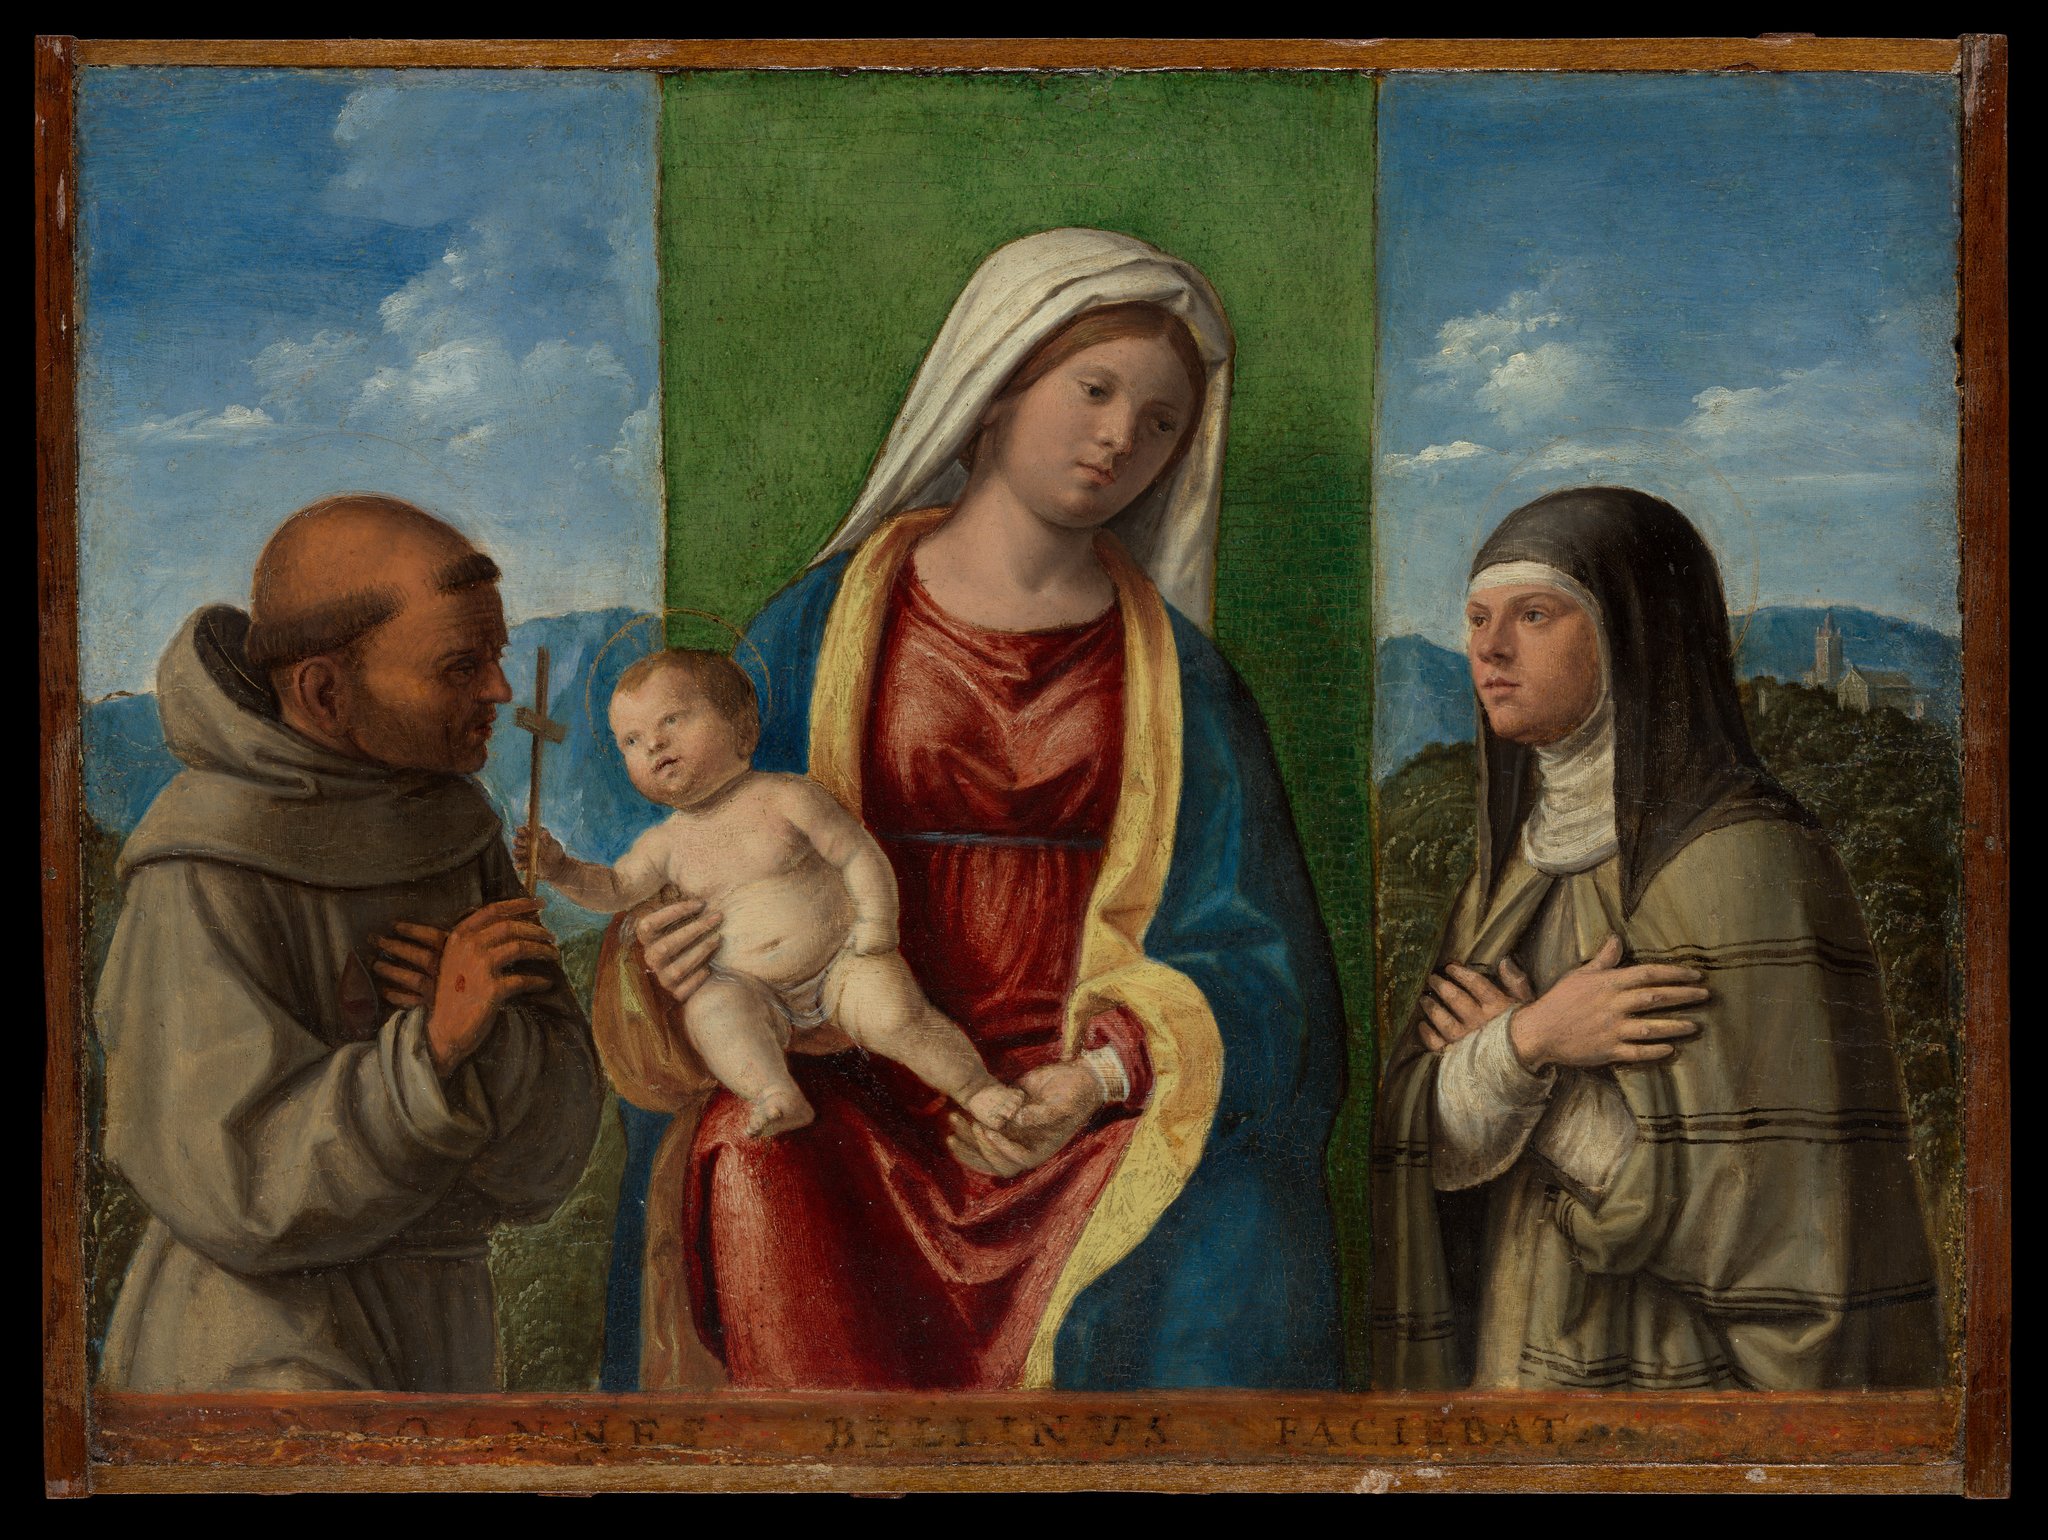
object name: painting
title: Madonna and Child with Saints Francis and Clare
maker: cima da conegliano (giovanni battista cima)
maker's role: artist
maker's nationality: italian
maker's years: 1459-1518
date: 1510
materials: oil, wood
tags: madonna and child,saint francis,saints